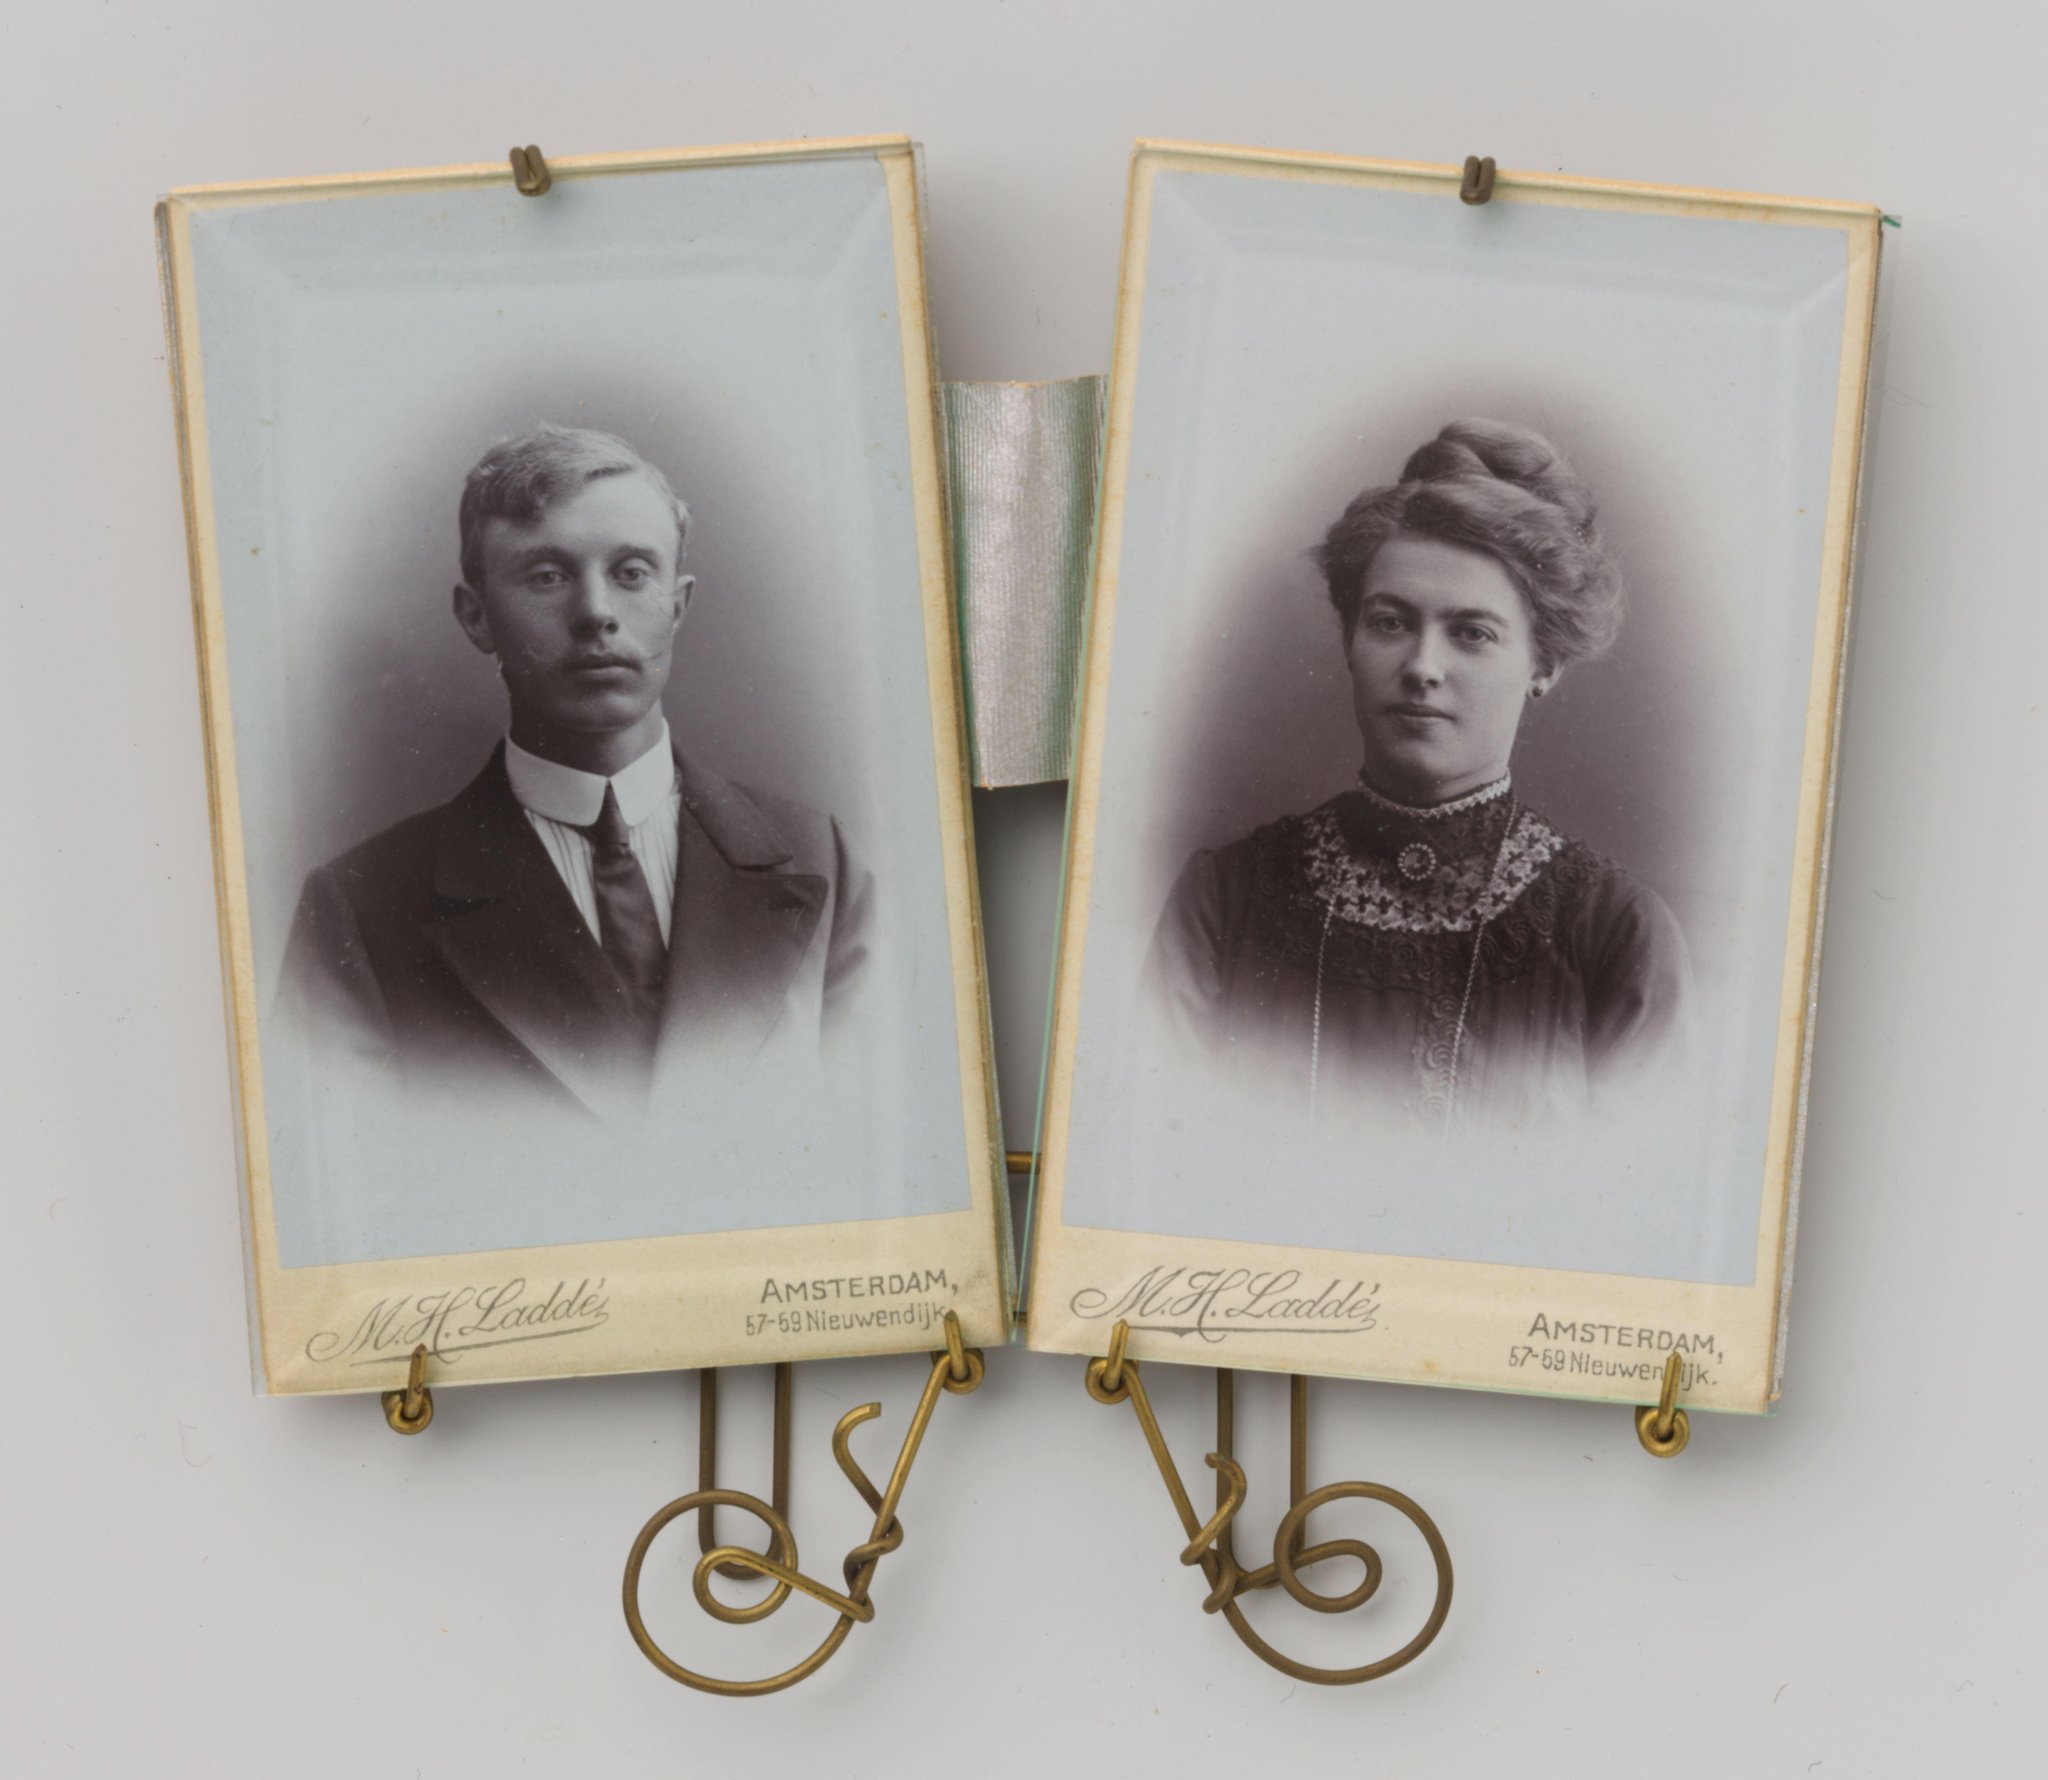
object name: carte de visite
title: Portret van een onbekende man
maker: machiel hendricus laddé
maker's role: fotograaf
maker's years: 1866-1932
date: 1892-1906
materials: paper, cardboard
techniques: collodion silver print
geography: amsterdam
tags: adult man, anonymous historical person portrayed, amsterdam